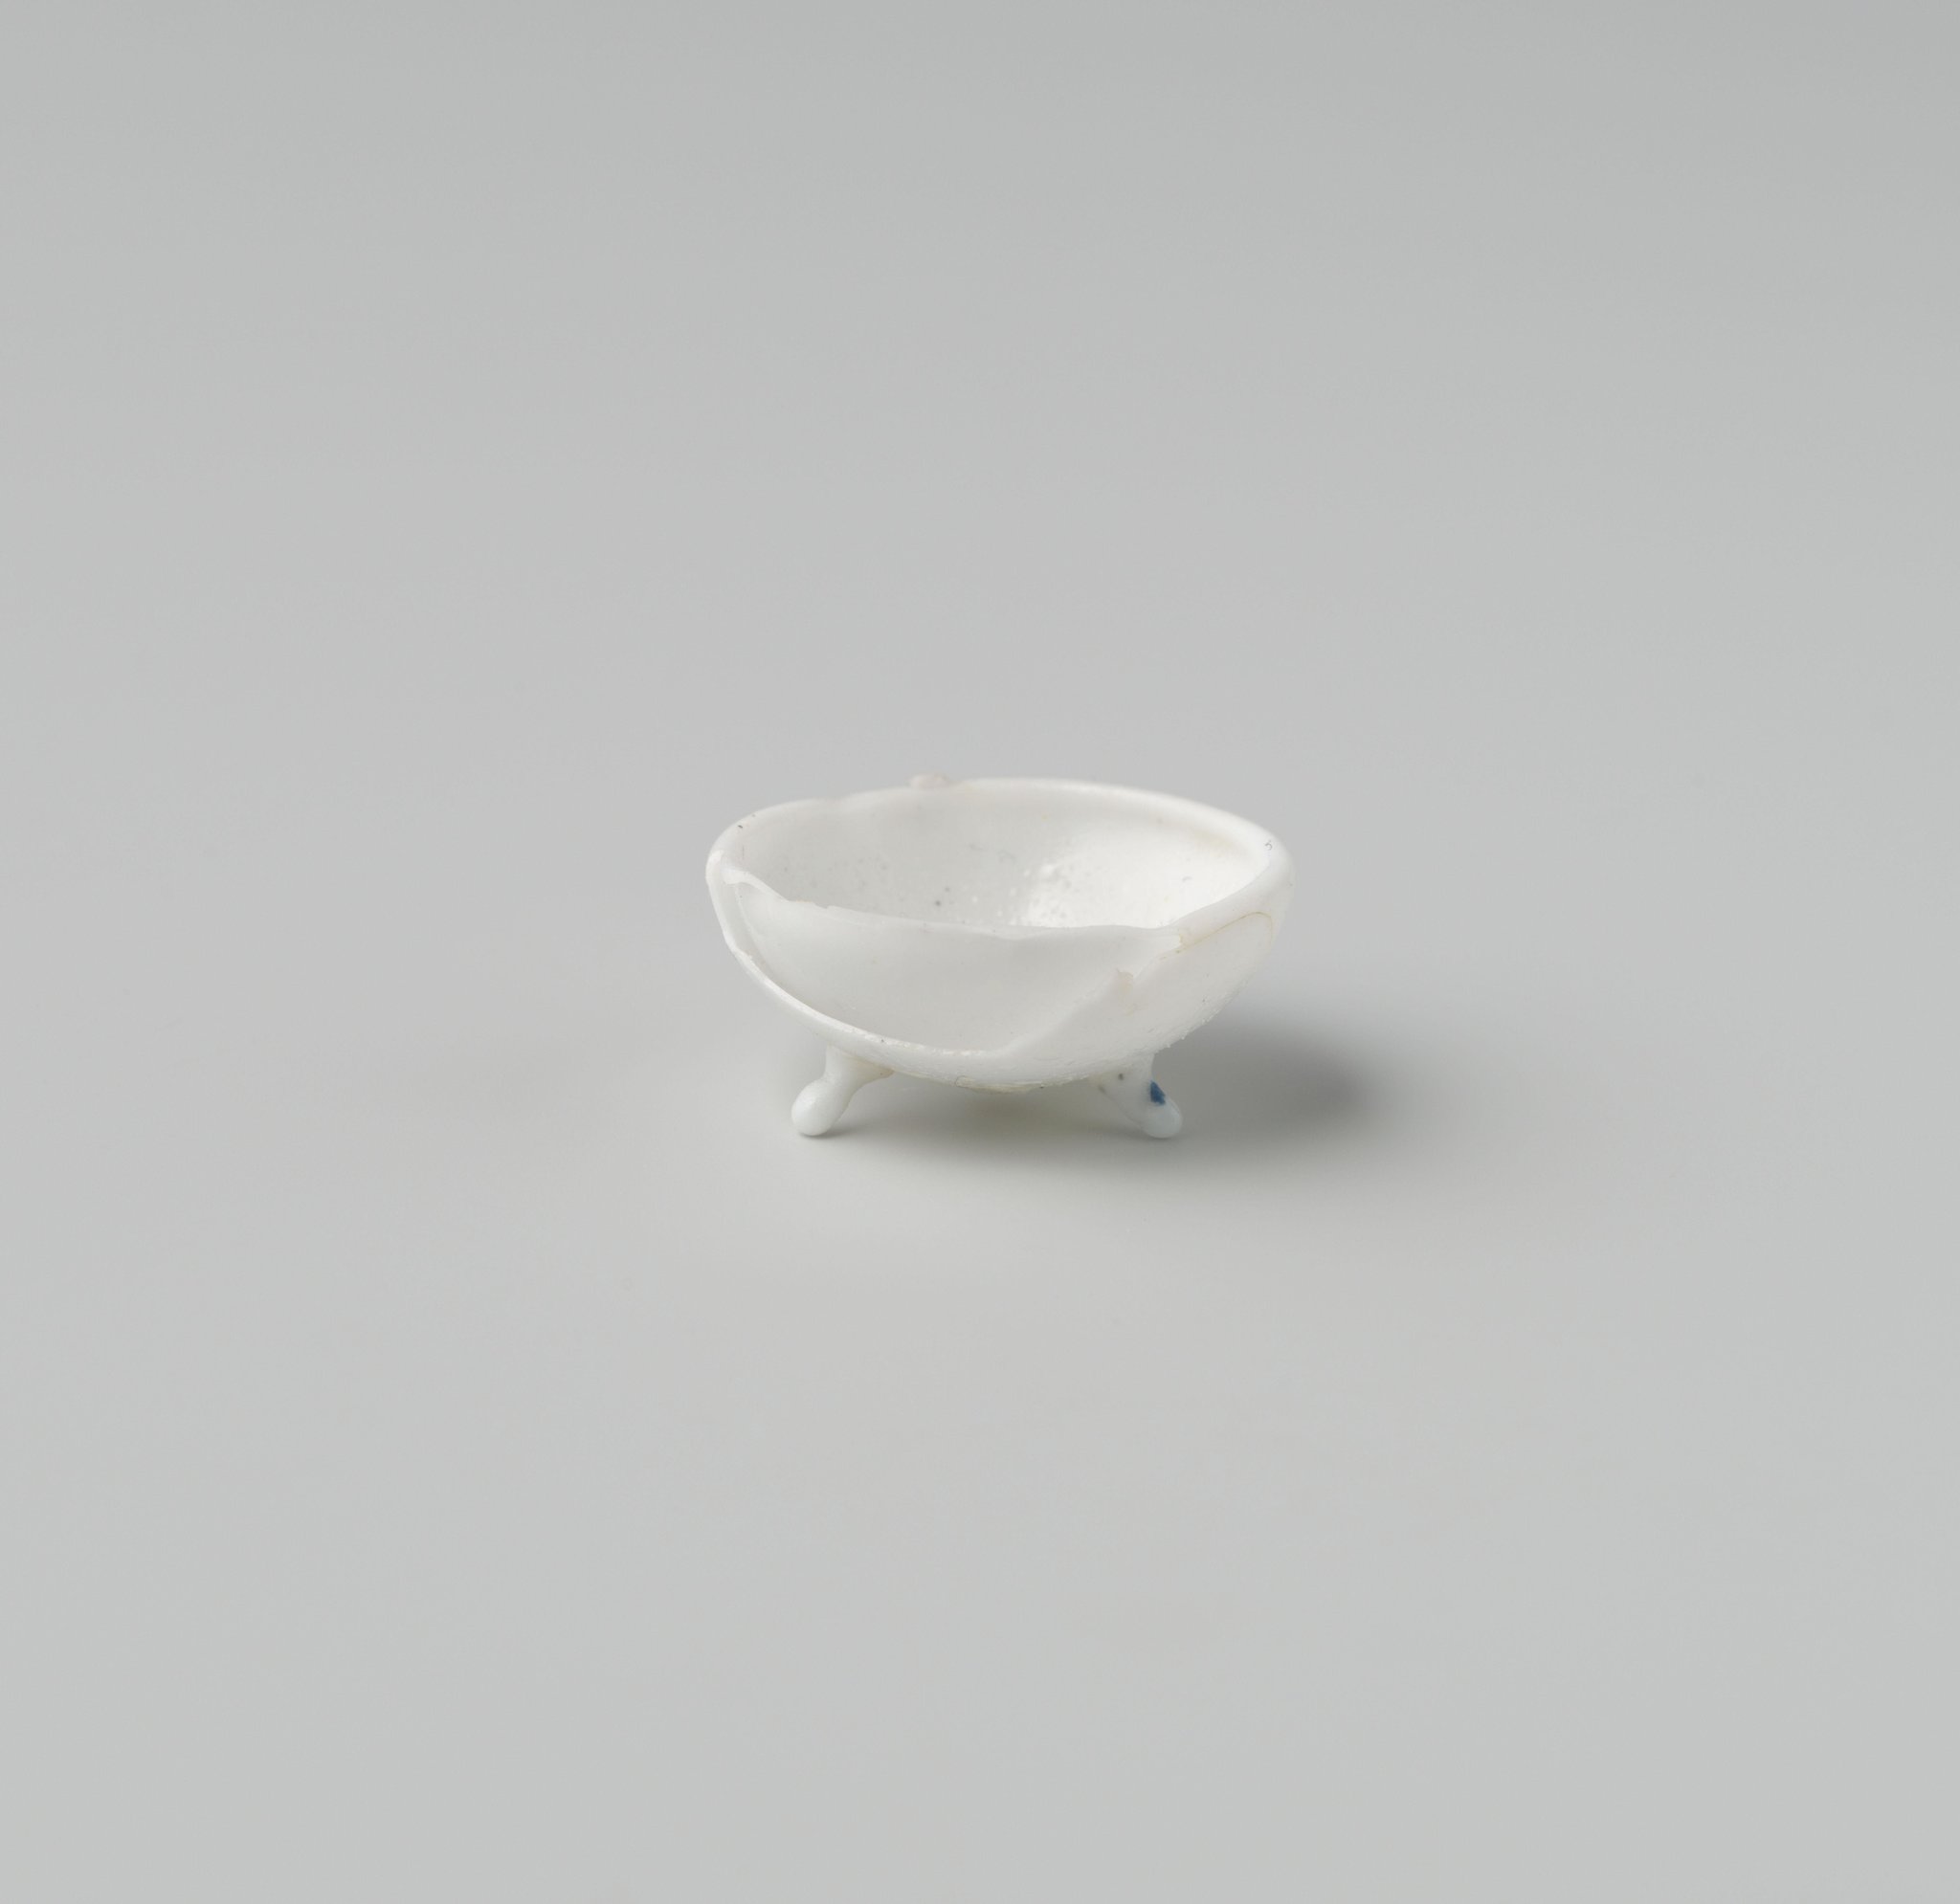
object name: bowl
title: Kom van opaak wit glas (waarschijnlijk imitatie wit aardewerk); dubbelwandige bak op drie pootjes.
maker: Anonymous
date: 1675-1710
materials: glass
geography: amsterdam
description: Kom van opaak wit glas, waarschijnlijk imitatie wit aardewerk; dubbelwandige bak op drie pootjes.